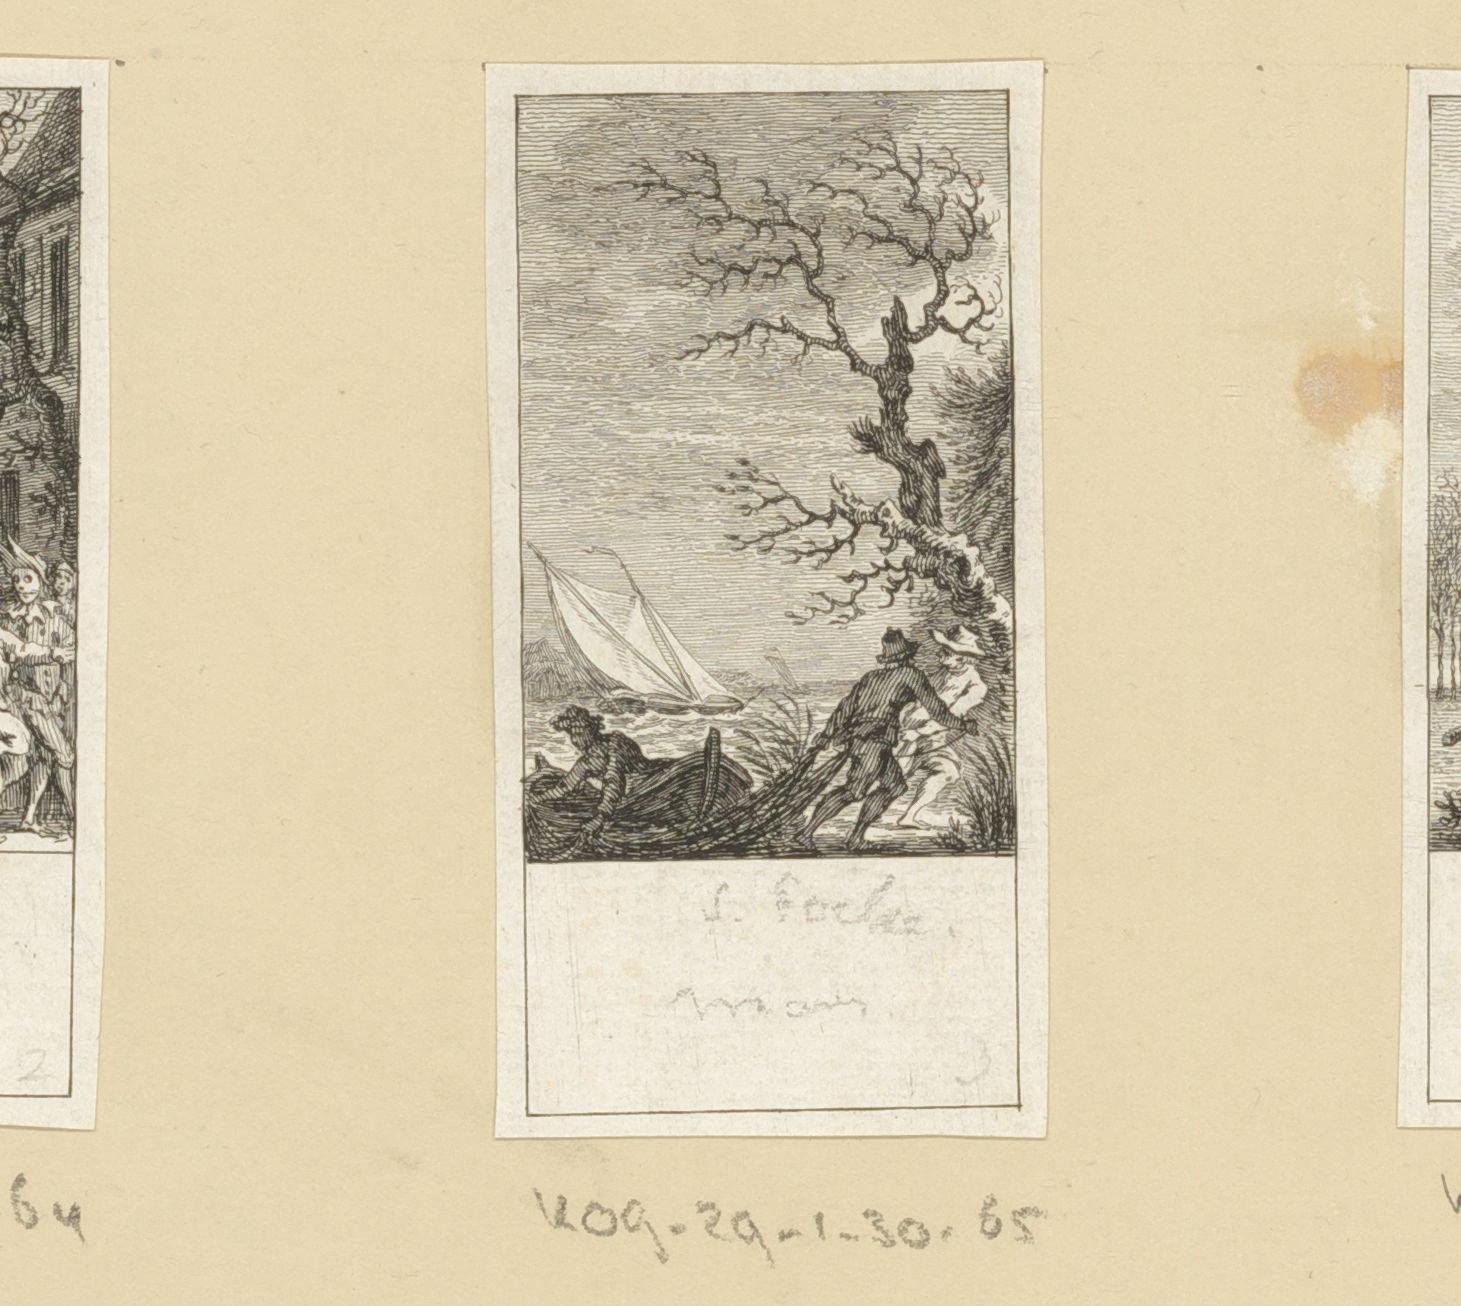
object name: print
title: Twaalf maanden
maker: simon fokke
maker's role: draughtsman, print maker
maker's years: 1712-1784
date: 1722-1784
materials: paper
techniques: etching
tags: march ~ other concepts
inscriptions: stamp, collector's mark: Lugt 1641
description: Uit een serie van twaalf prenten, de verbeelding van de maand maart. Vissers trekken een boot het strand op. Onderwerpsrubrieken binnen de Atlas Zeden en Gewoonten: Zeden en Gewoonten in engeren zin. Volksleven. Zinnebeeldige voorstellingen uit het volkleven op serieprenten. Maanden en diversen (allegorieën).